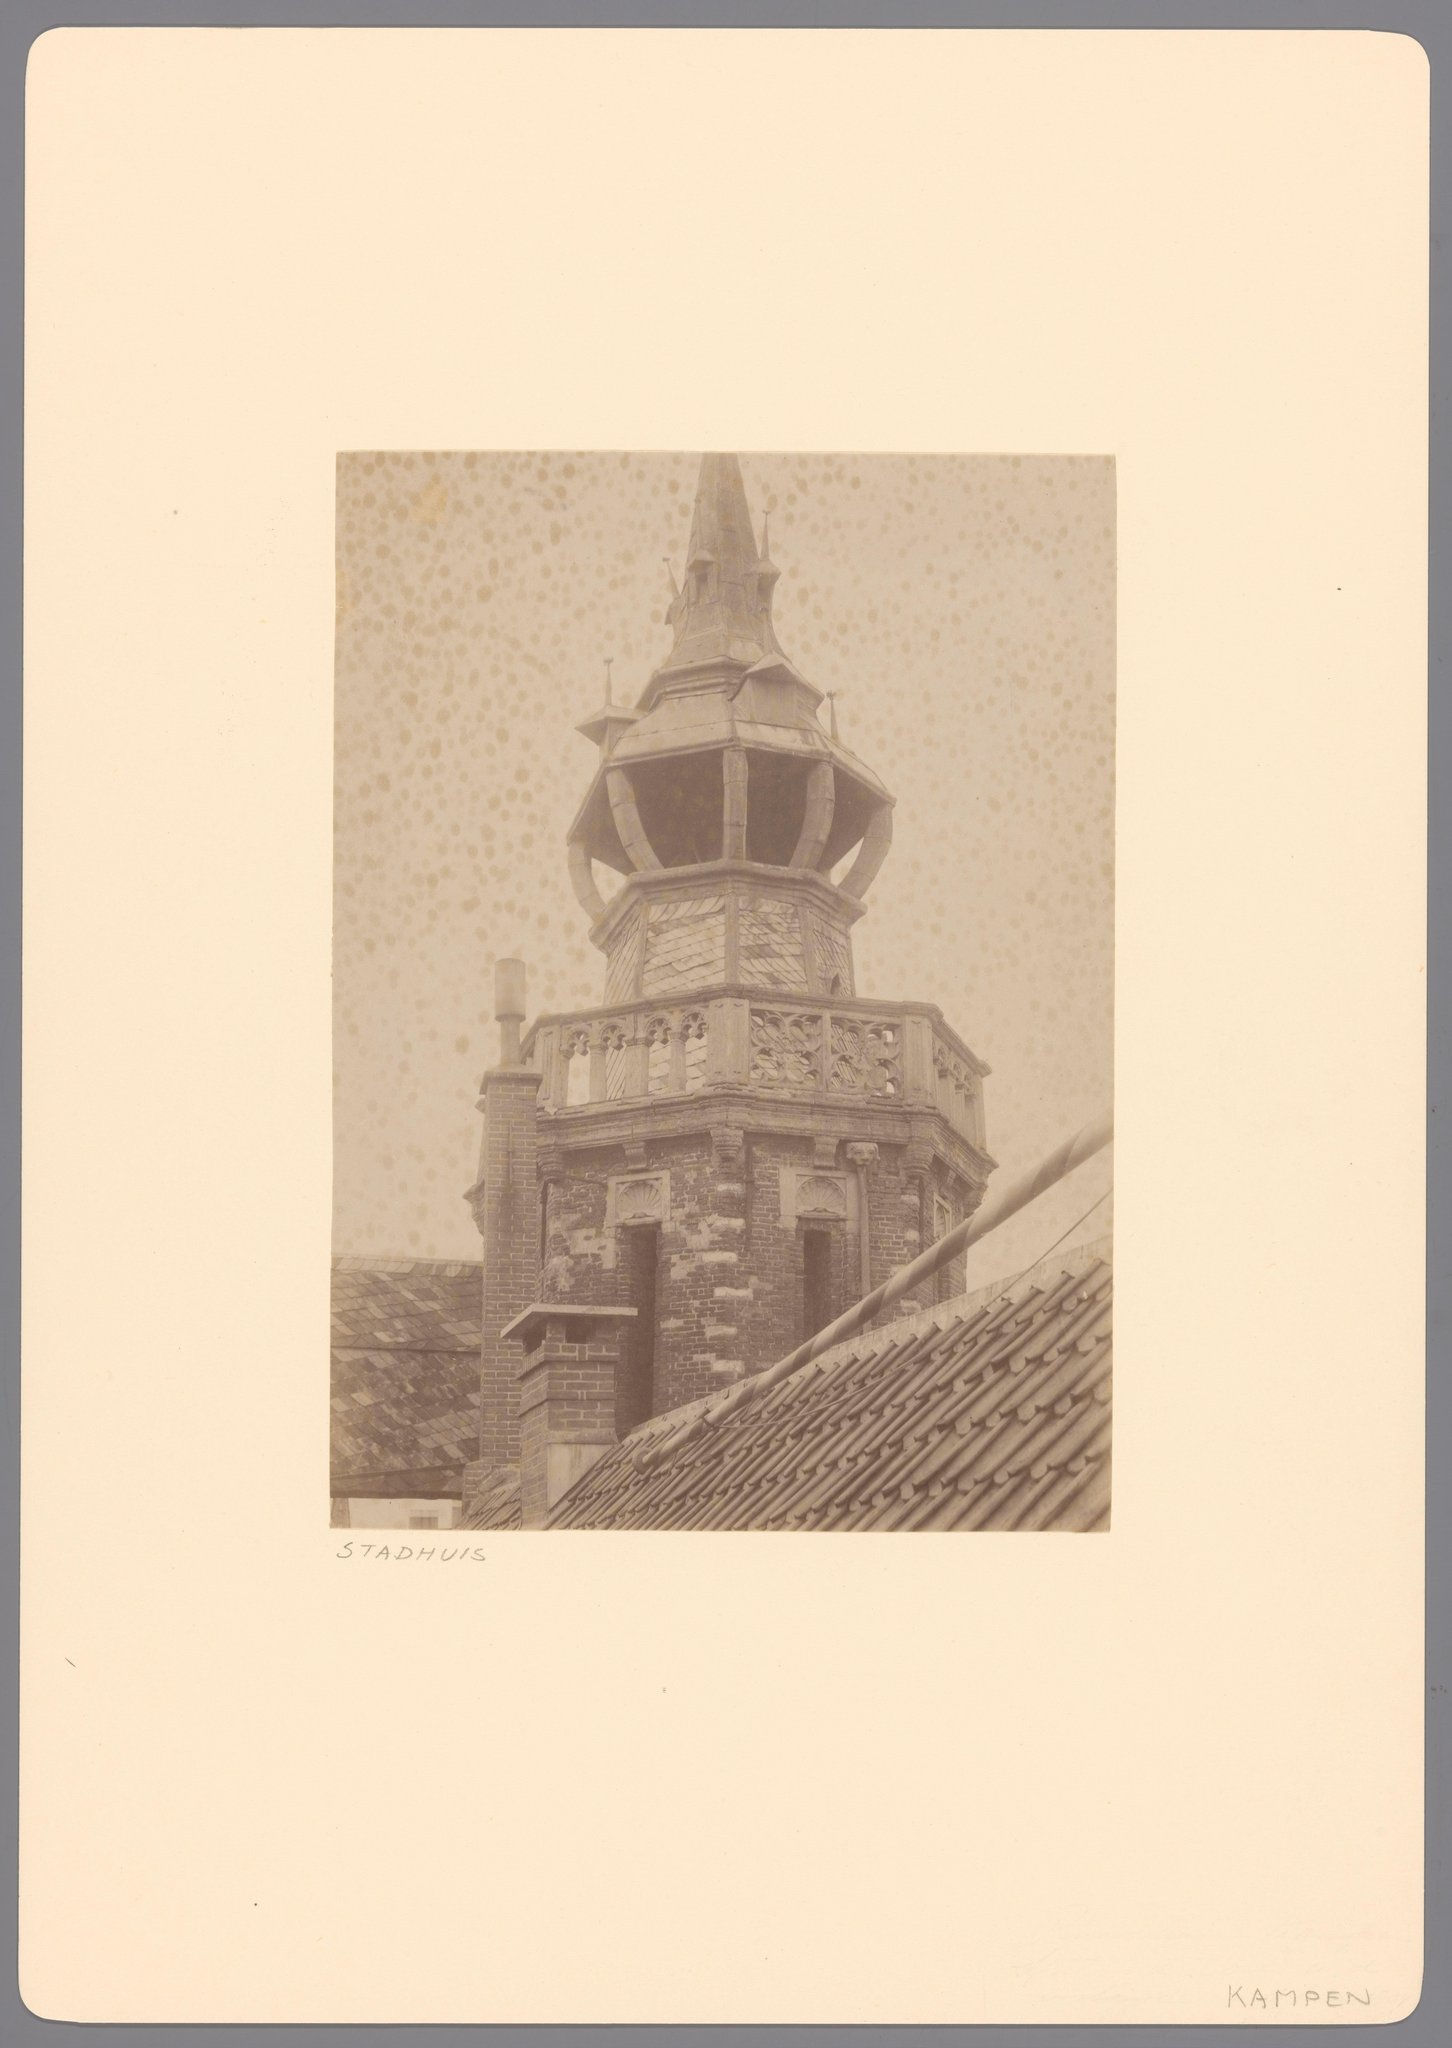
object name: photograph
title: Toren van het stadhuis van Kampen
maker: anoniem (monumentenzorg)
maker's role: fotograaf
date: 1904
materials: cardboard, photographic support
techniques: albumen print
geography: kampen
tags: townhall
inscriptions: annotation: ‘Kampen Raadhuis/ spits v.d. toren aan de oostzijde/ april 1904’, annotation: ‘Stadhuis/ Kampen’